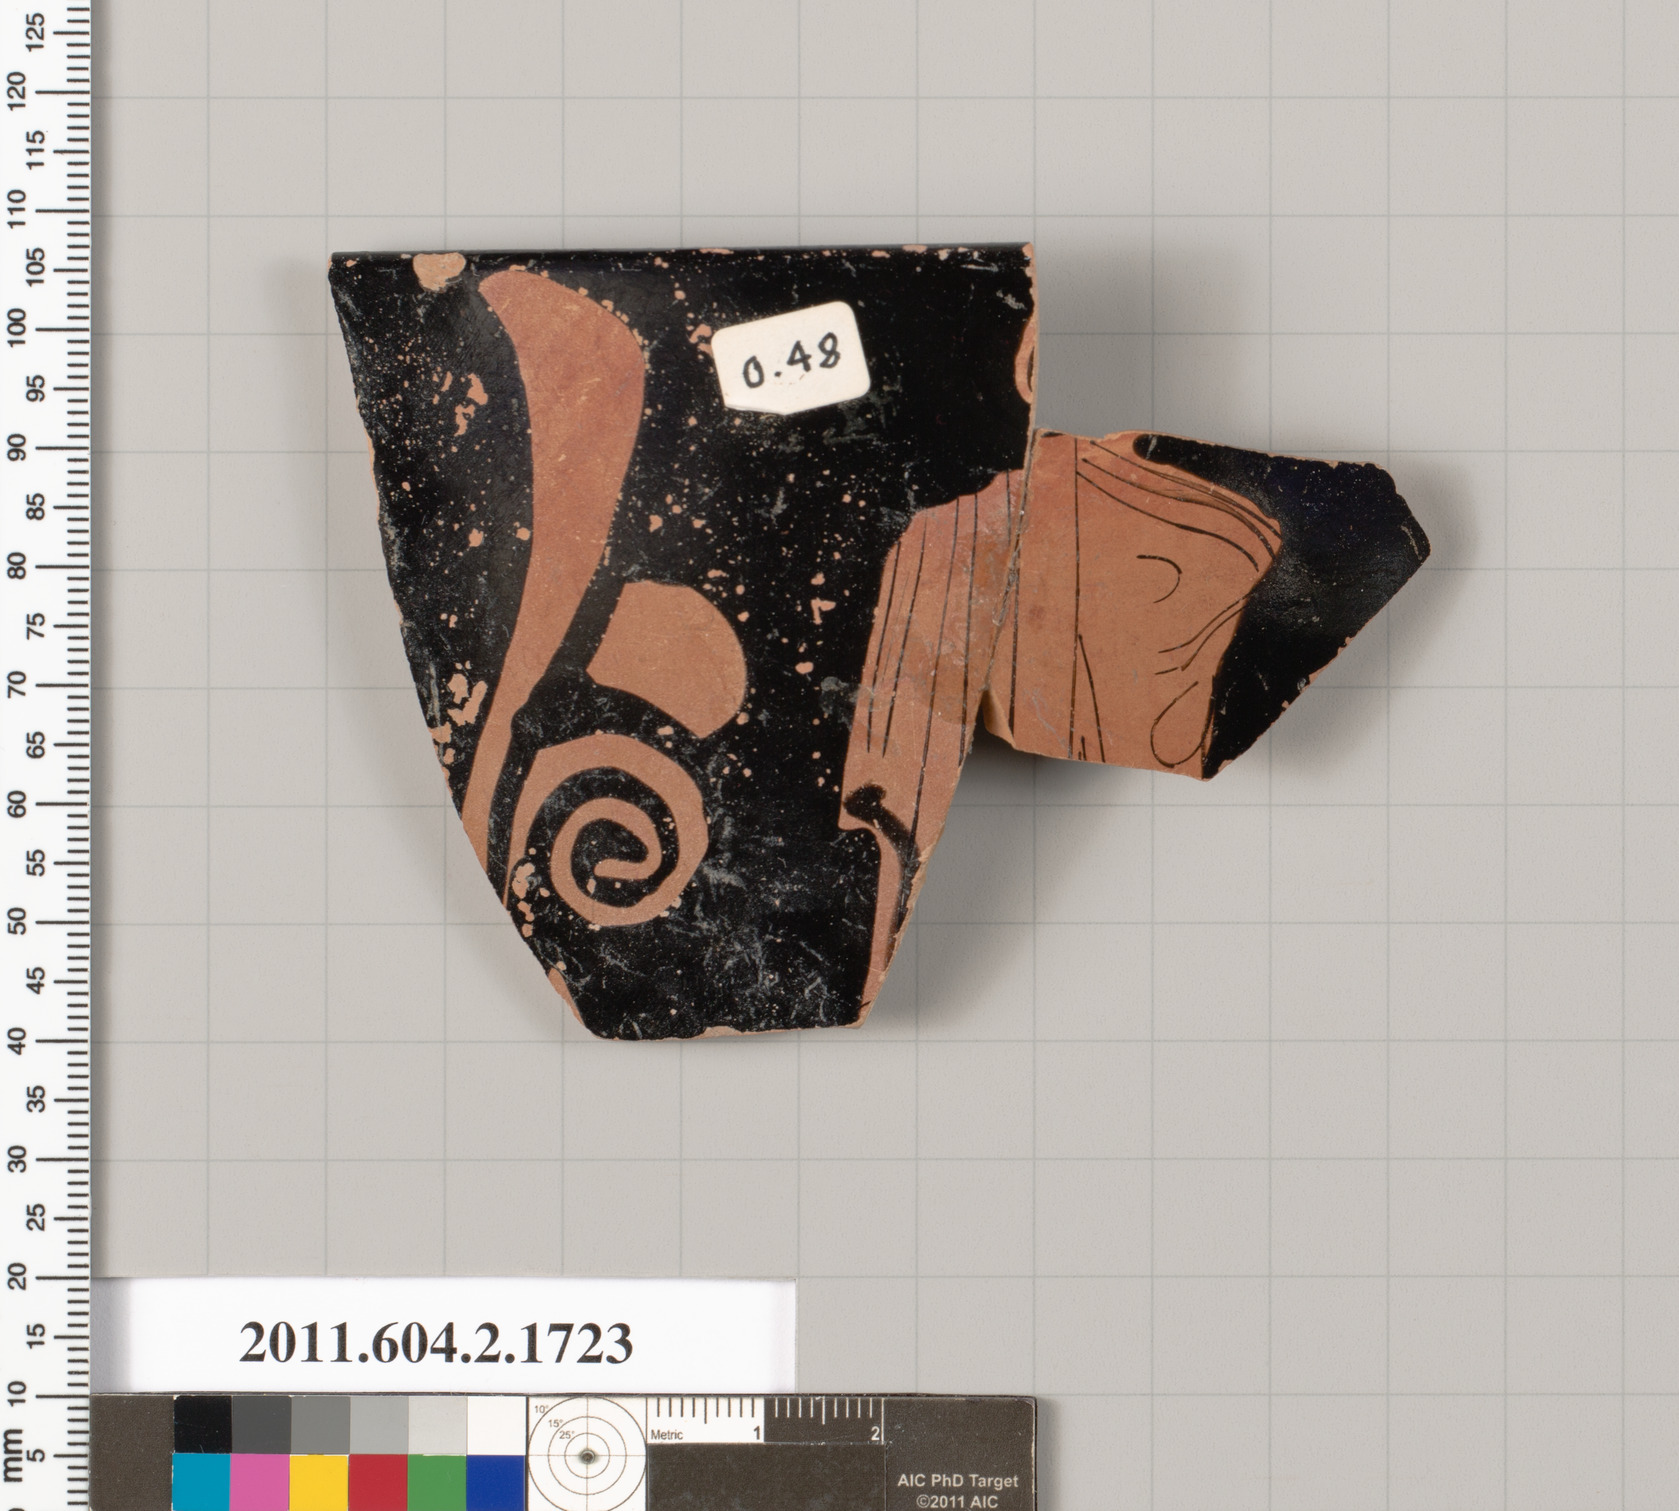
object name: skyphos fragment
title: Terracotta fragment of a skyphos (deep drinking cup)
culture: greek, attic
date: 450-426 BCE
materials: terracotta